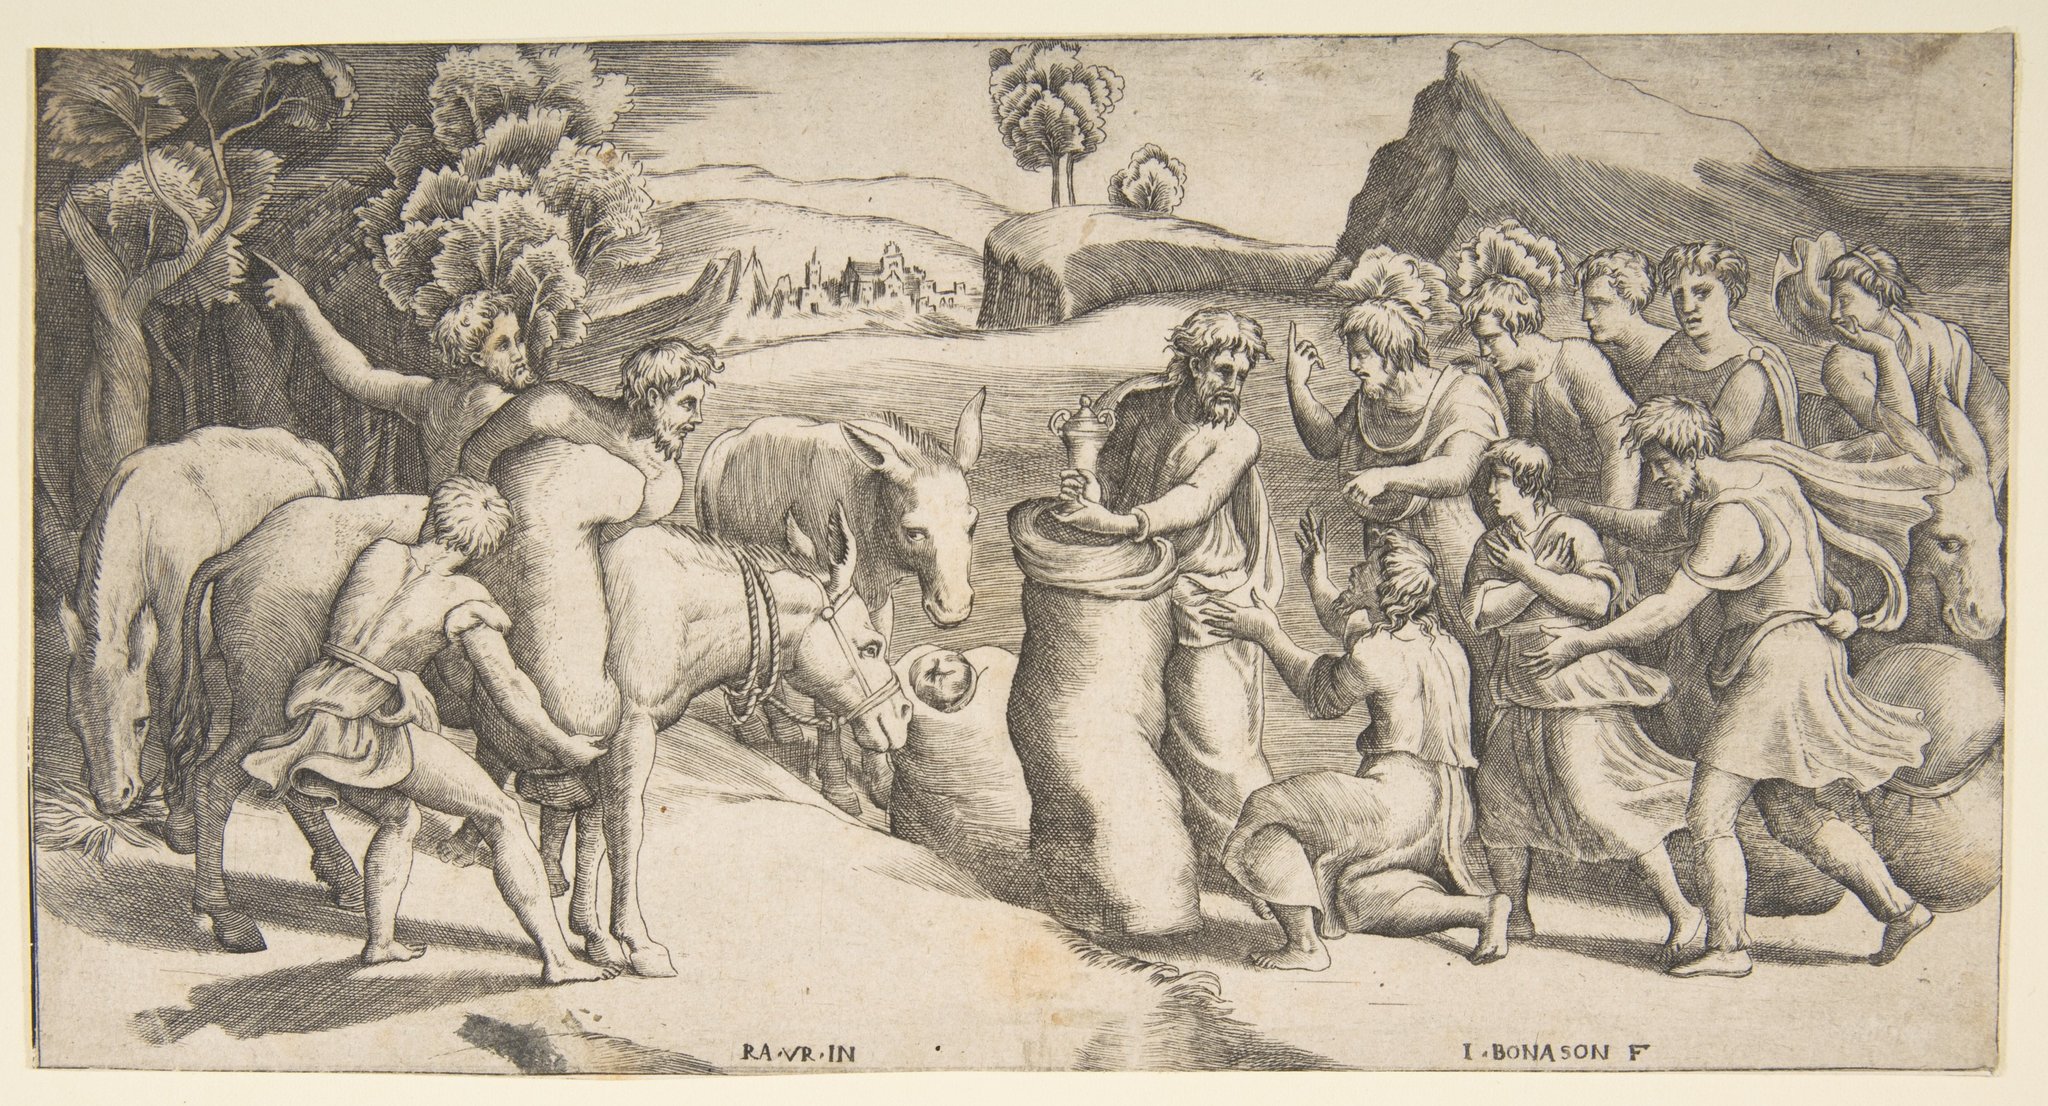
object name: print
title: Joseph's cup being discovered in Benjamin's sack of grain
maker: giulio bonasone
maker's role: artist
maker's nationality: italian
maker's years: 1510-1576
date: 1531-1576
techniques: engraving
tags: men,cows,horses,trees